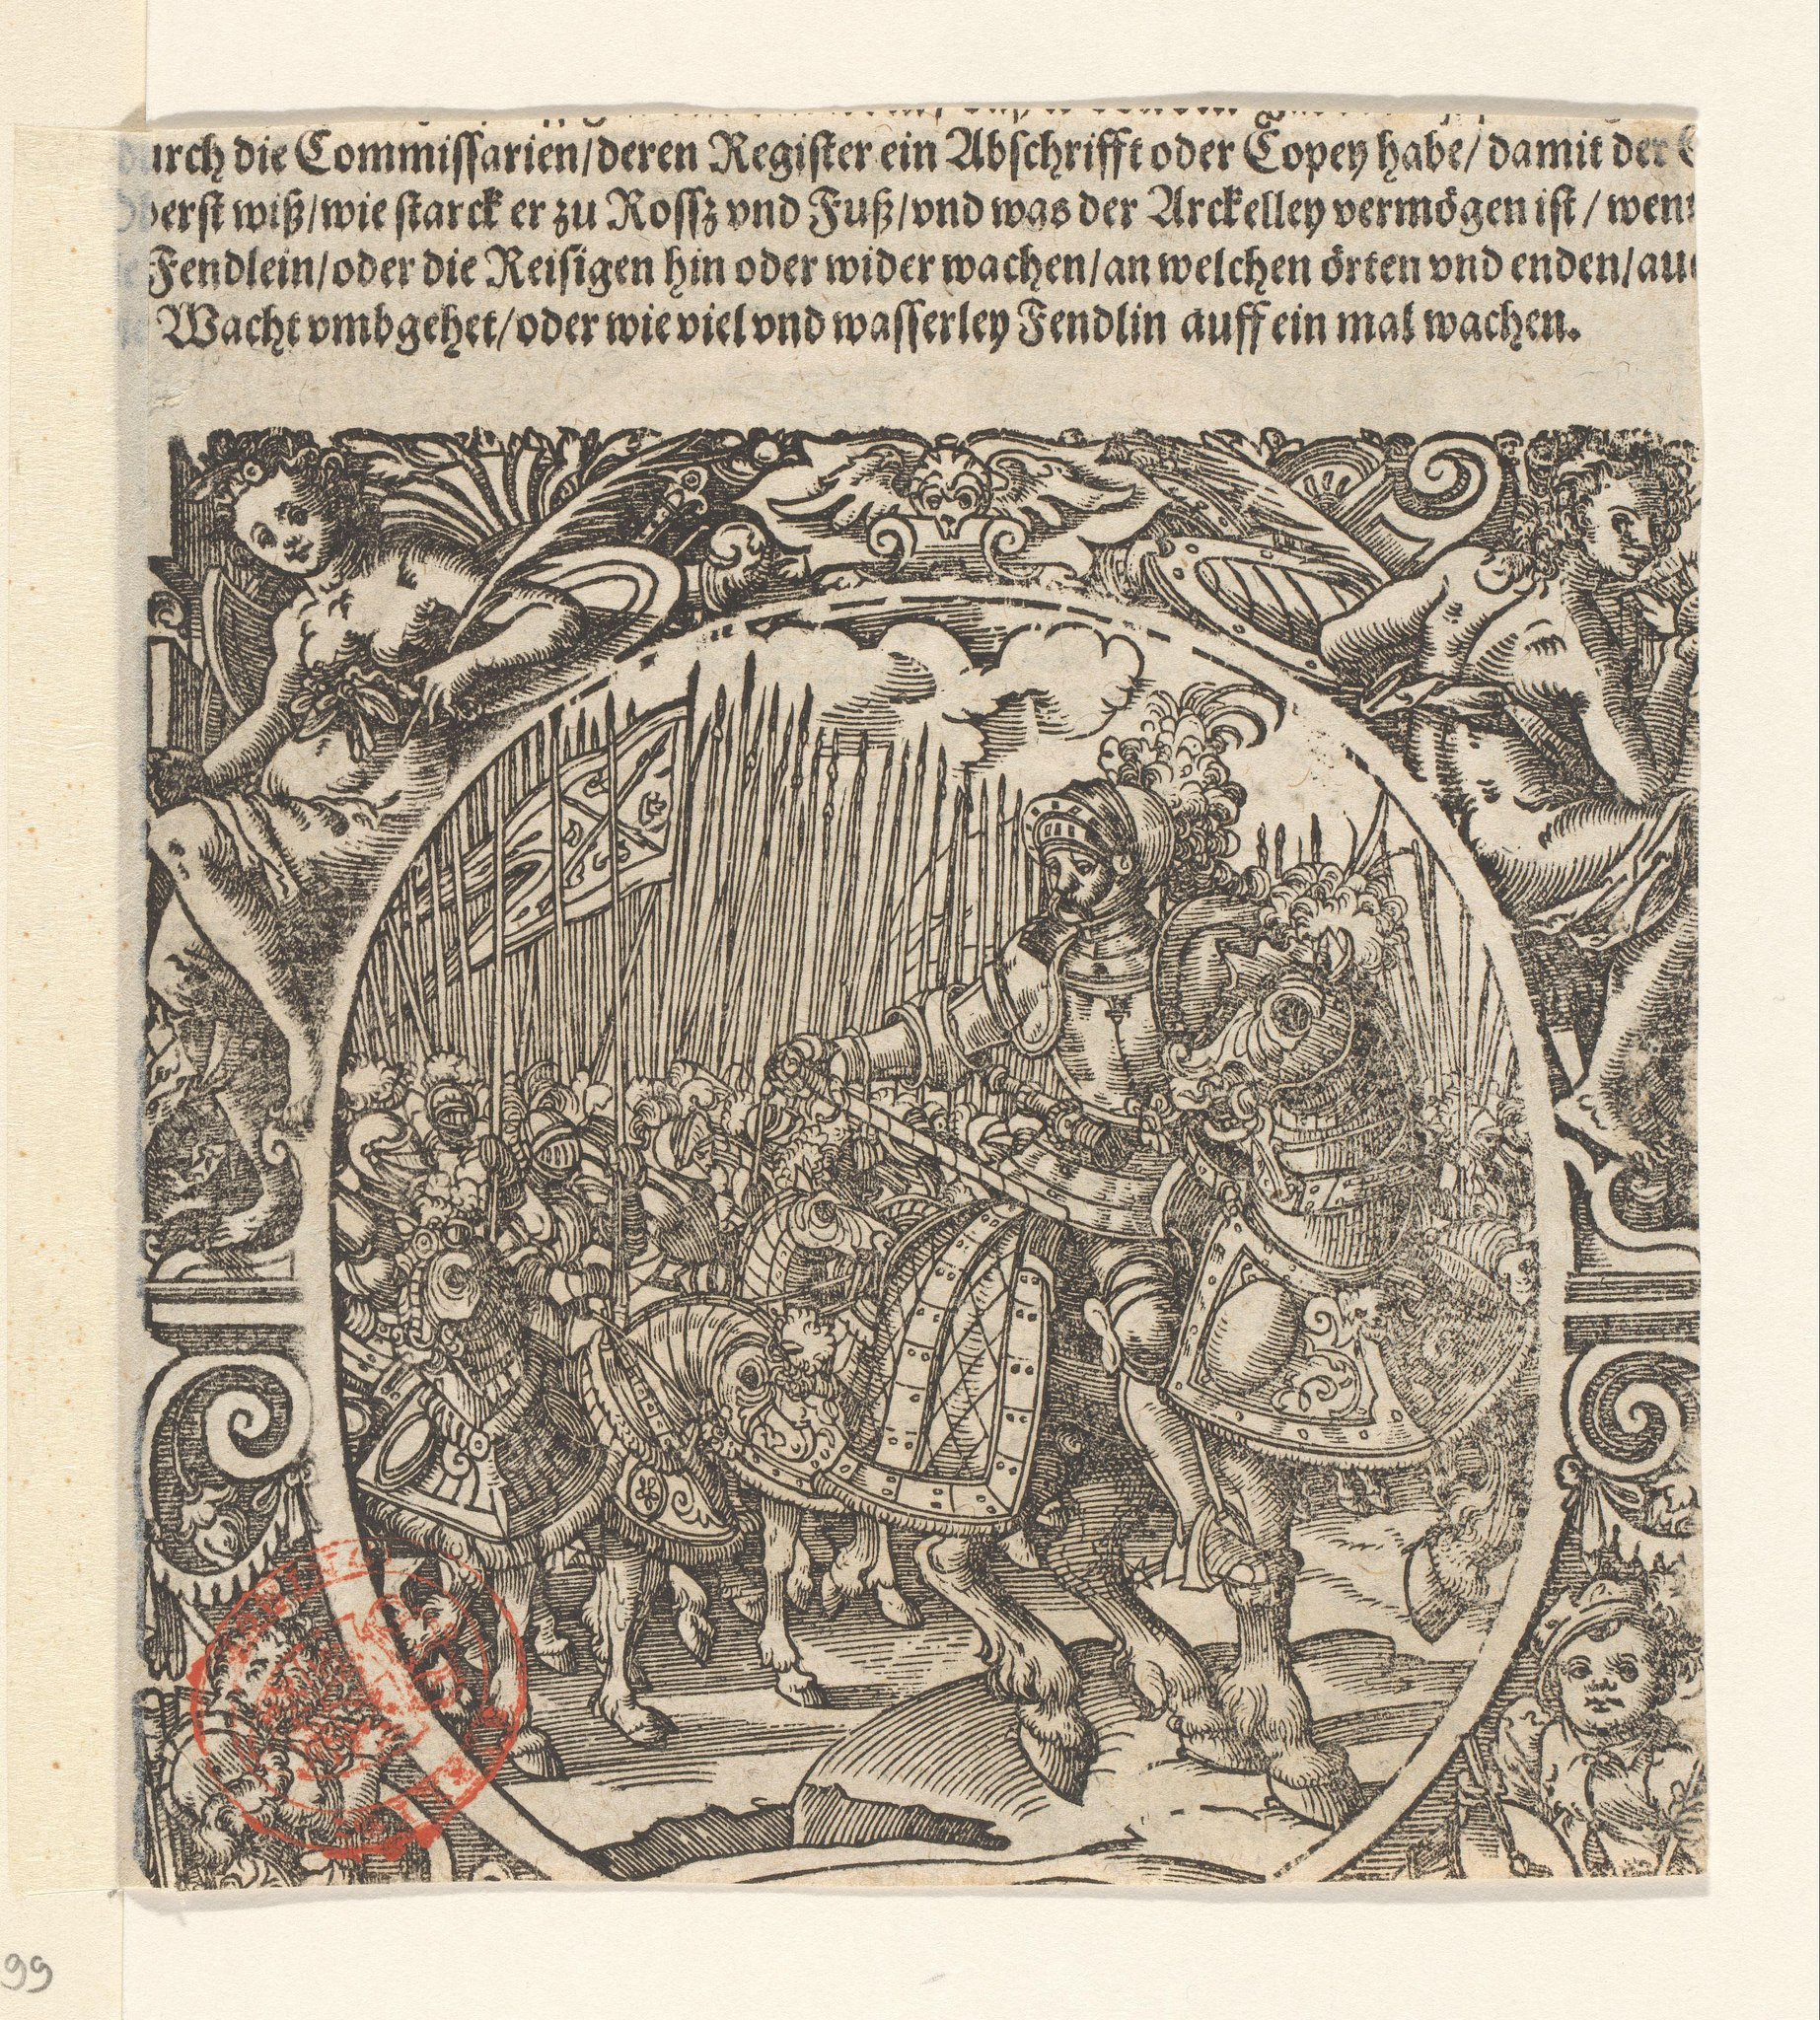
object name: print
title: Generaal voor zijn cavalerie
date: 1573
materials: paper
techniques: woodcut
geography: nuremberg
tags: commander-in-chief, general, marshal, warfare; military affairs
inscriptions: collector's mark: Lugt 240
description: Zowel de voorstelling als de ornamentrand werd gebruikt voor verschillende edities van Leonhardt Fronspergers Kriegsbuch.